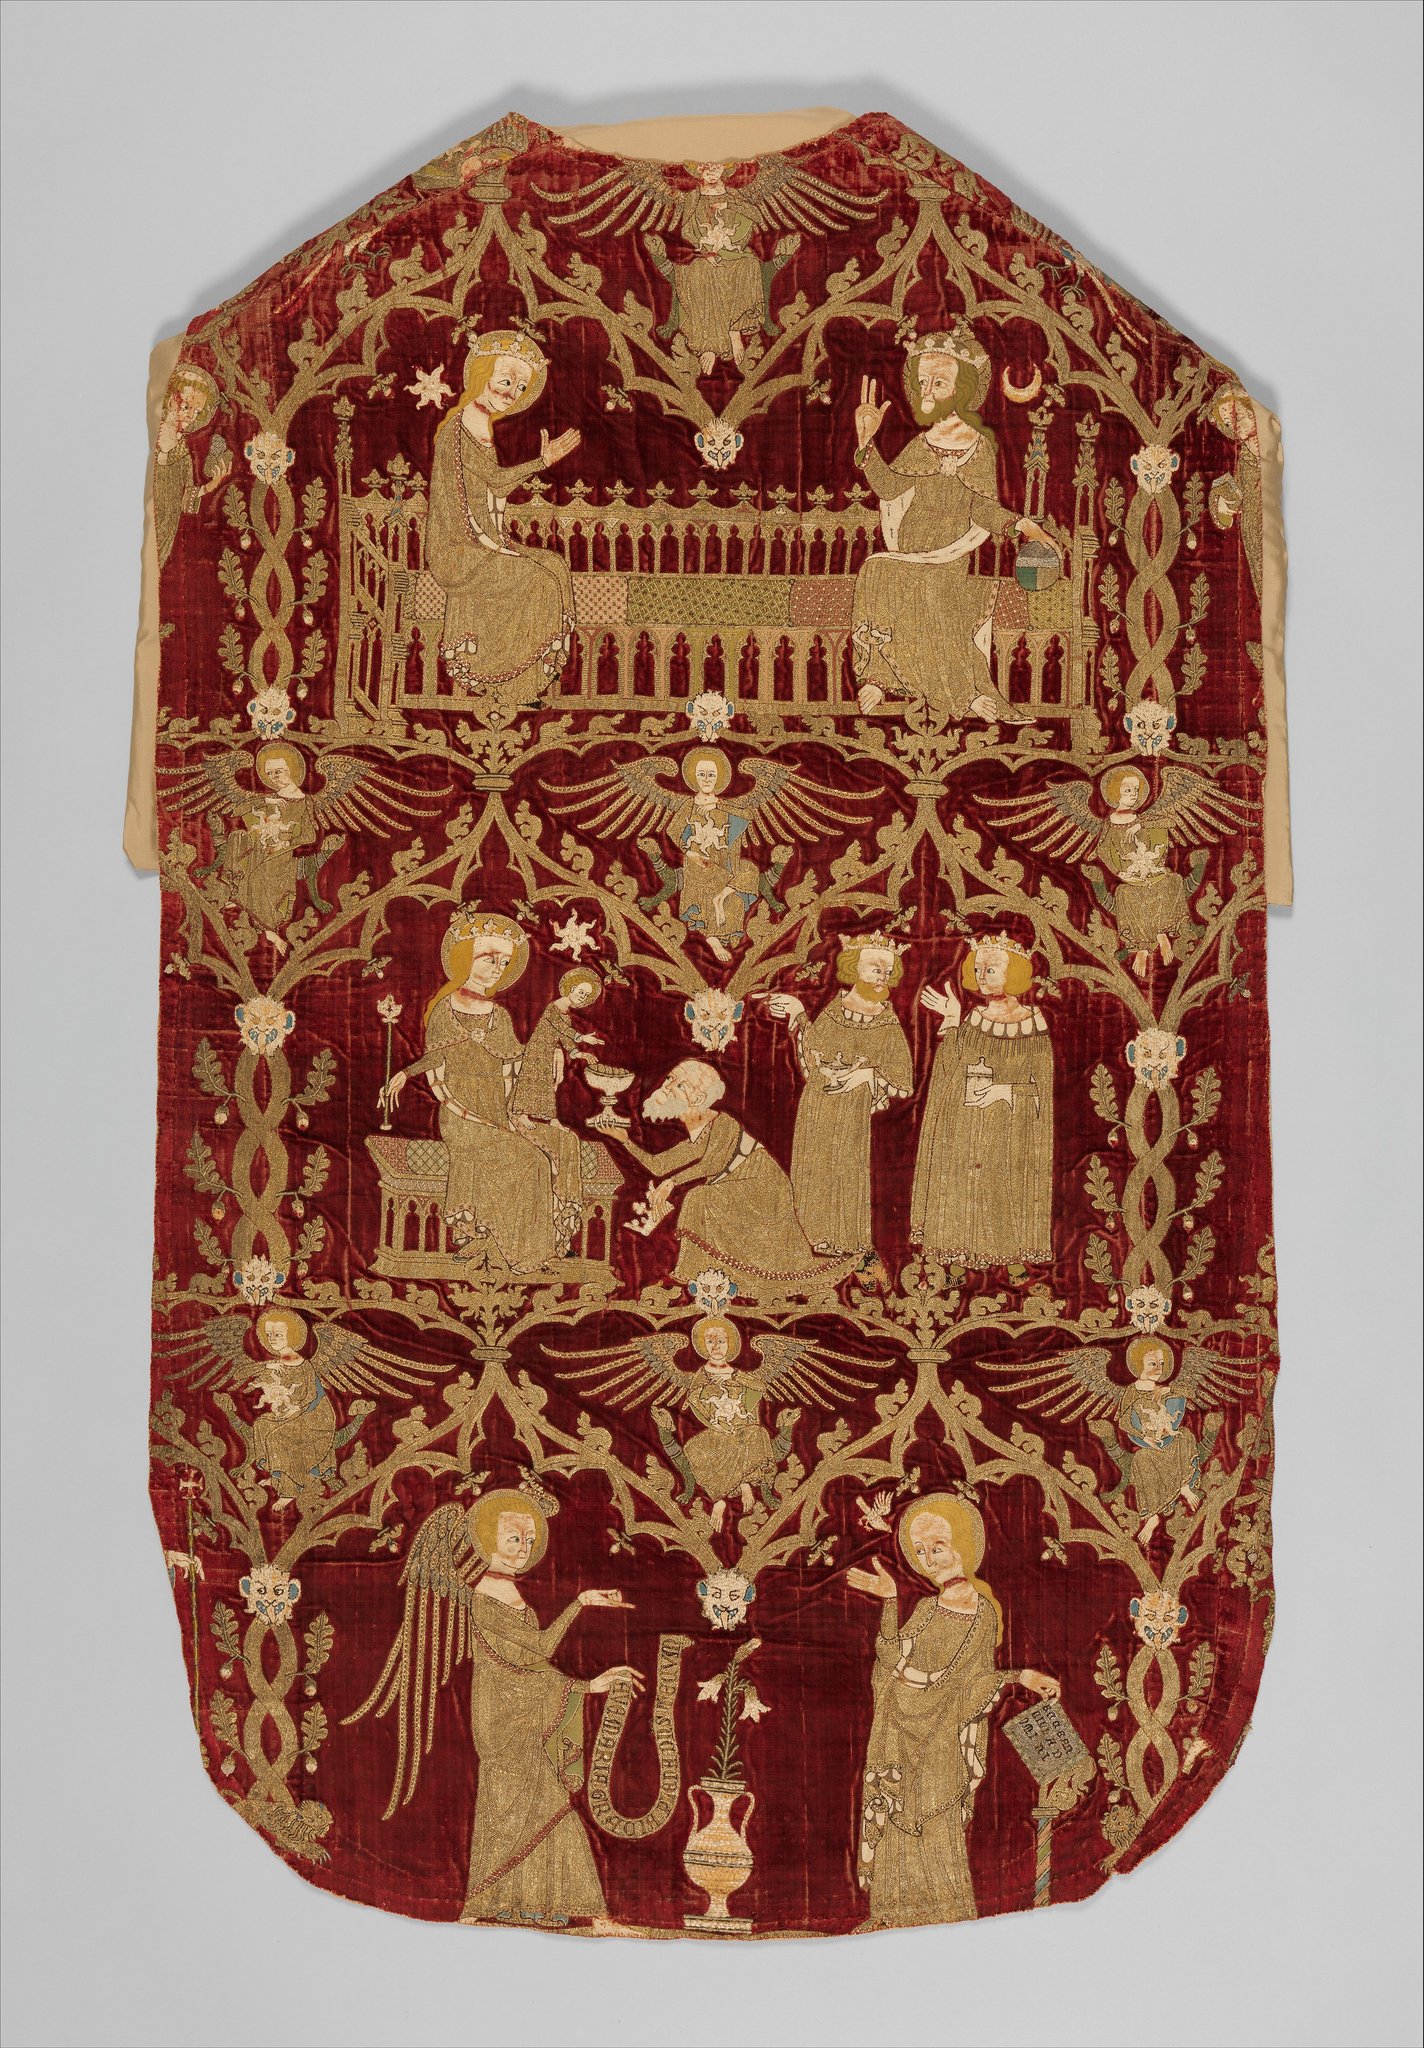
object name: chasuble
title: Chasuble (Opus Anglicanum)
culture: british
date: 1330-1350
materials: pearl, silk, silver, silver gilt, thread, velvet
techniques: embroidery, stitching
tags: christ,virgin mary,adoration of the magi,annunciation